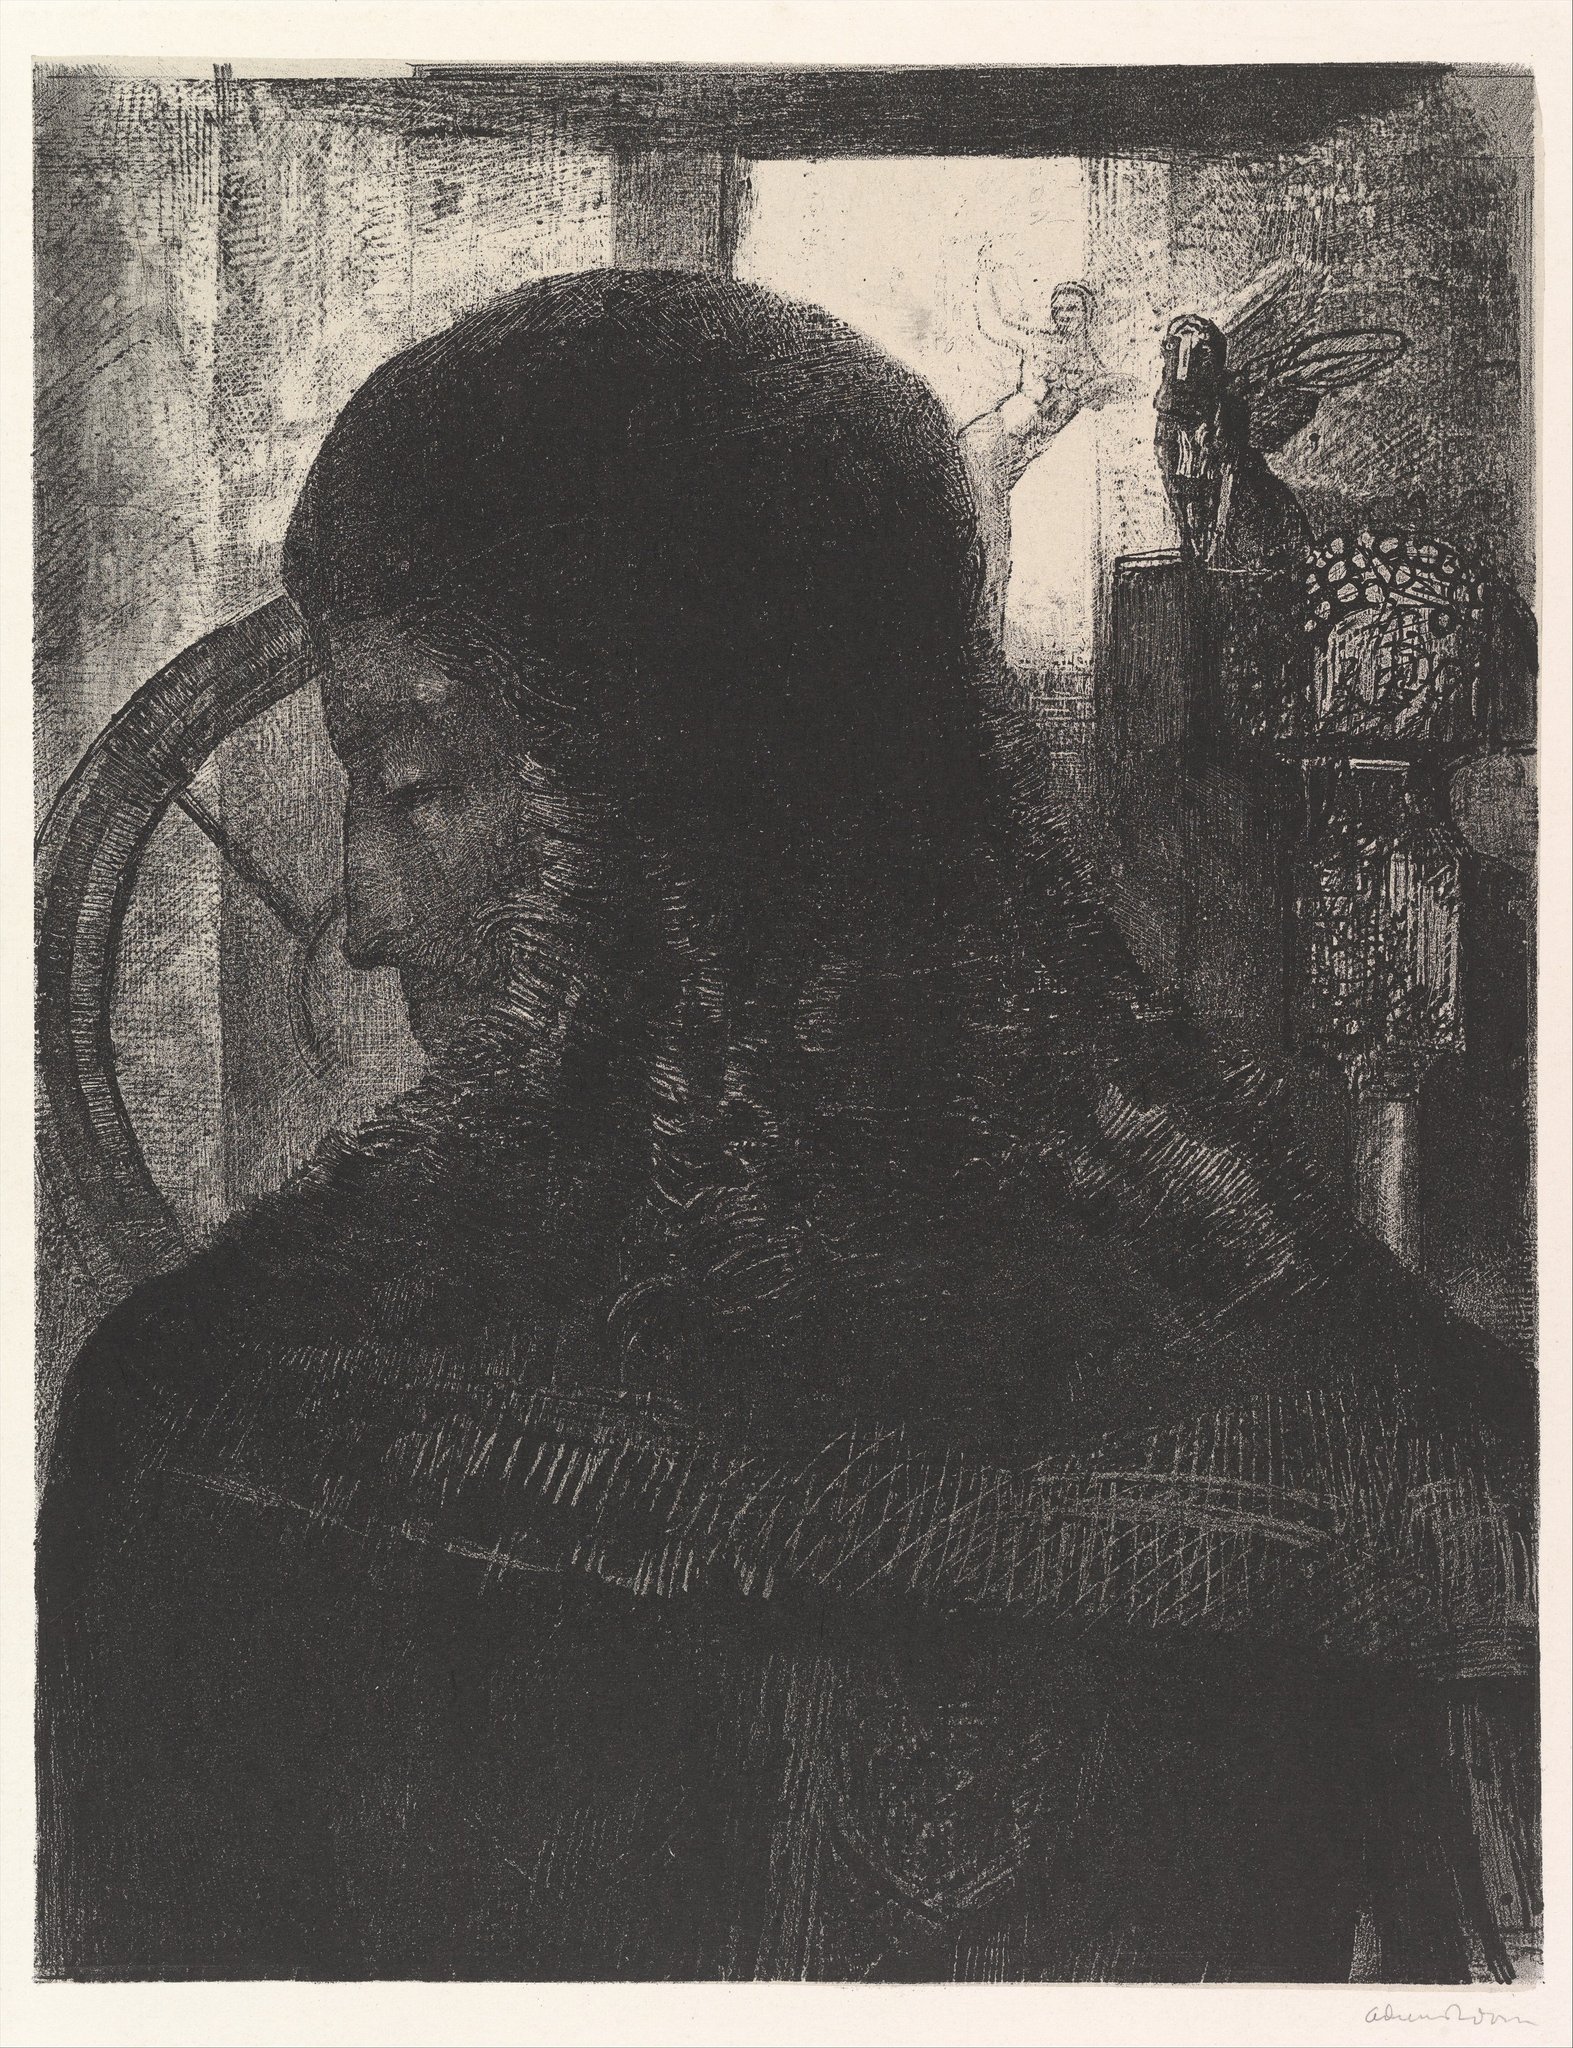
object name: print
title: The Old Knight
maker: odilon redon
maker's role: artist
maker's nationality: french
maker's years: 1840-1916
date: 1896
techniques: printmaking, lithograph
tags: men,knights